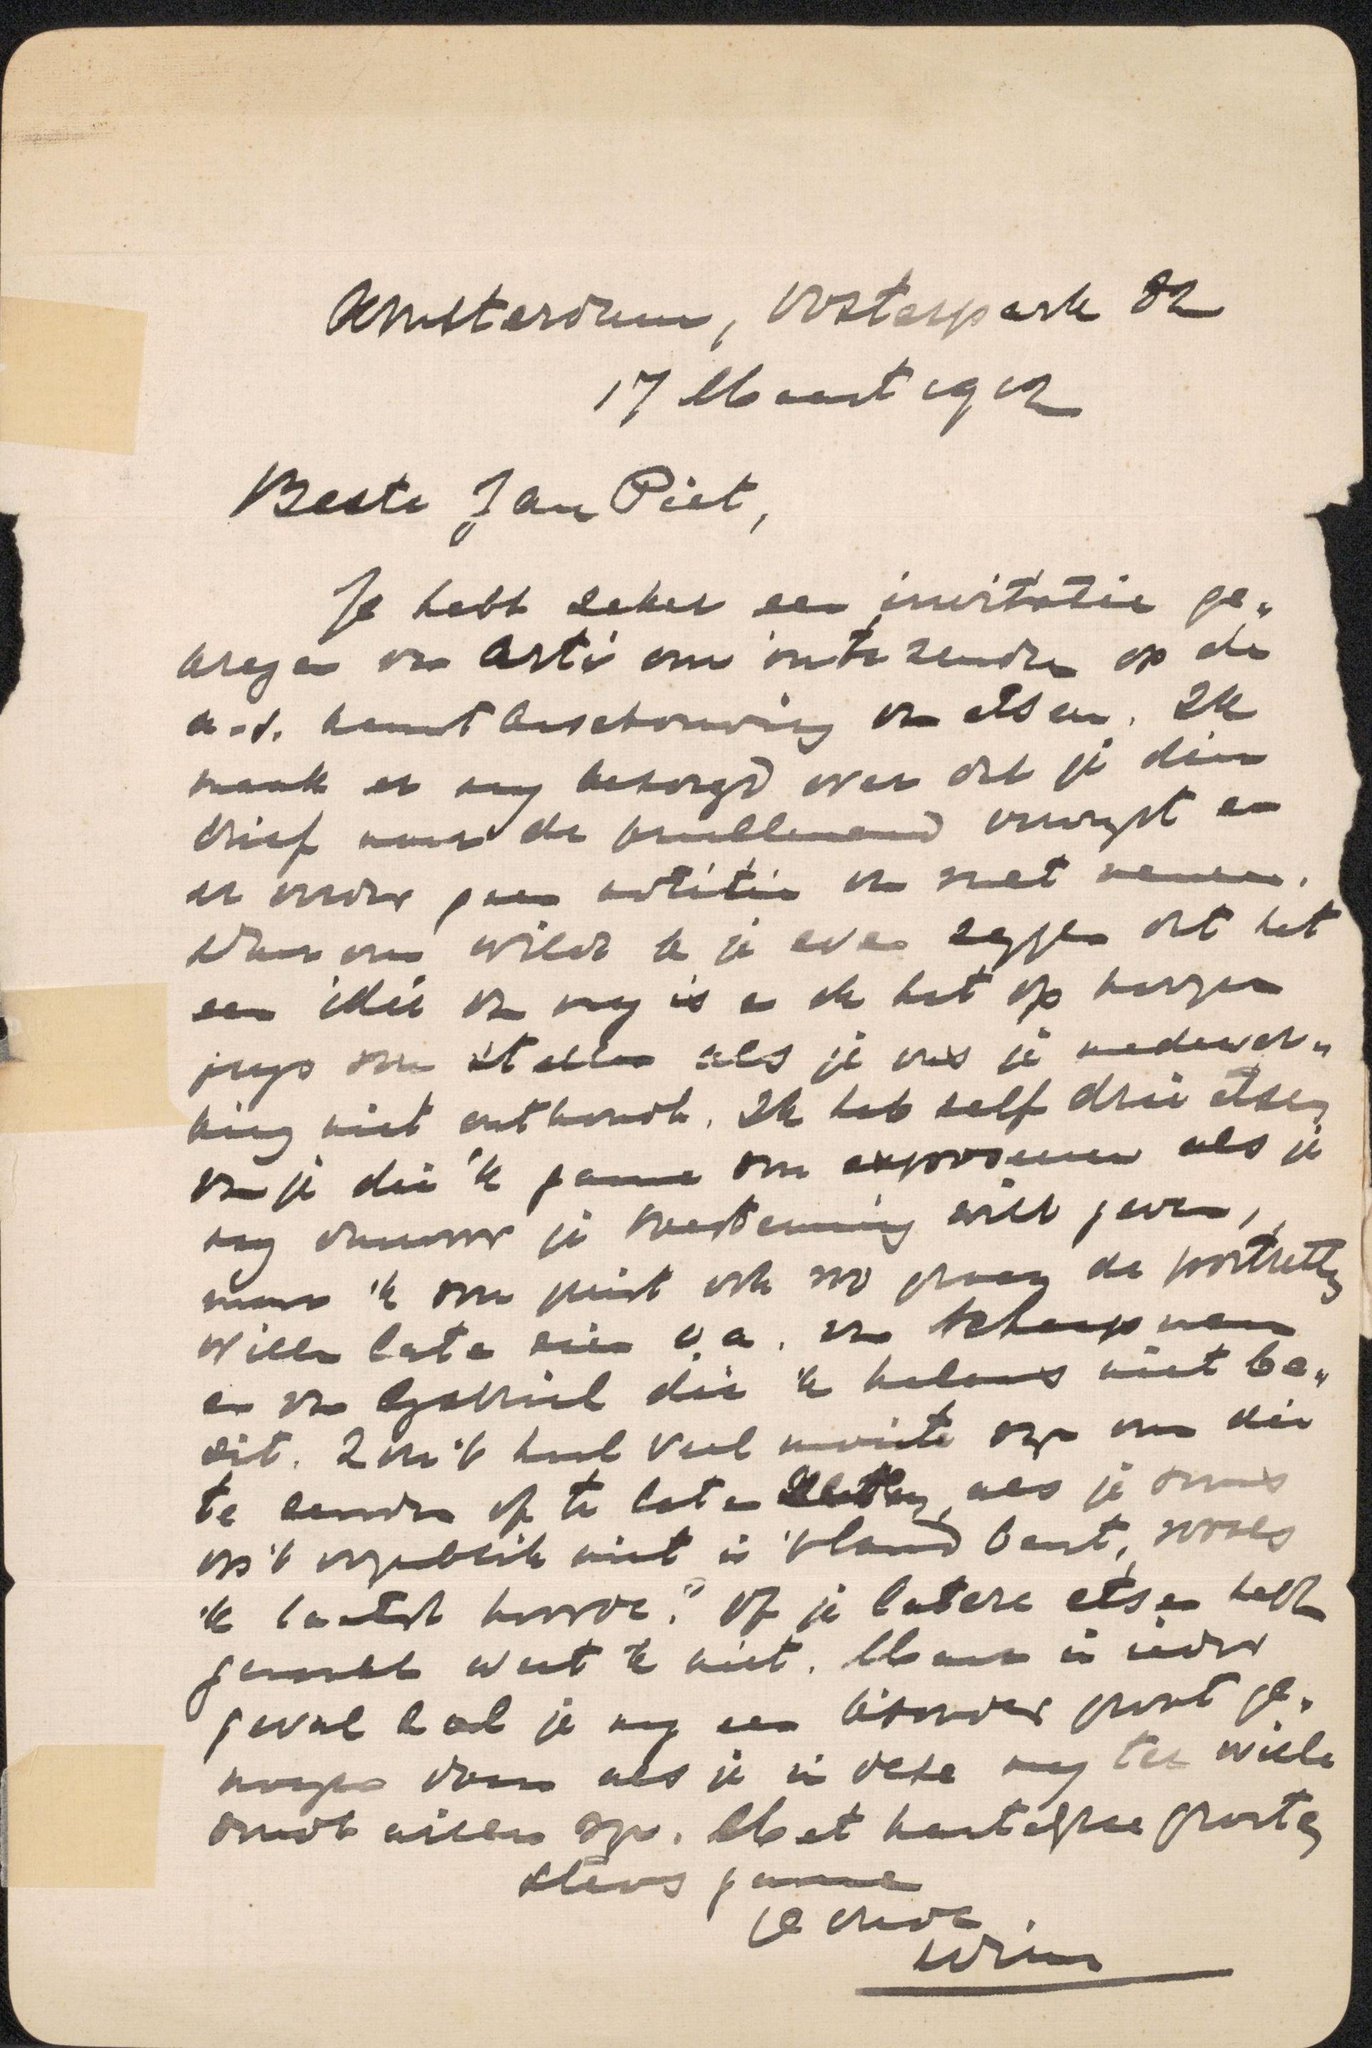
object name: letter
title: Brief aan Jan Veth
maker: willem witsen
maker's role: draughtsman, painter, print maker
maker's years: 1860-1923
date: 1912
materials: ink, paper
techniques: pen, writing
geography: amsterdam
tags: dordrecht, painter, designer, jan veth, amsterdam, print maker, draughtsman, paul joseph constantin gabriël, rome, priest, herman johannes aloysius maria schaepman, the hague, jan rinke, criticizing and discussing art, art criticism, the graphic arts, exhibition ~ art, historical persons (portraits and scenes from the life)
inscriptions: collector's mark: ‘RPK’